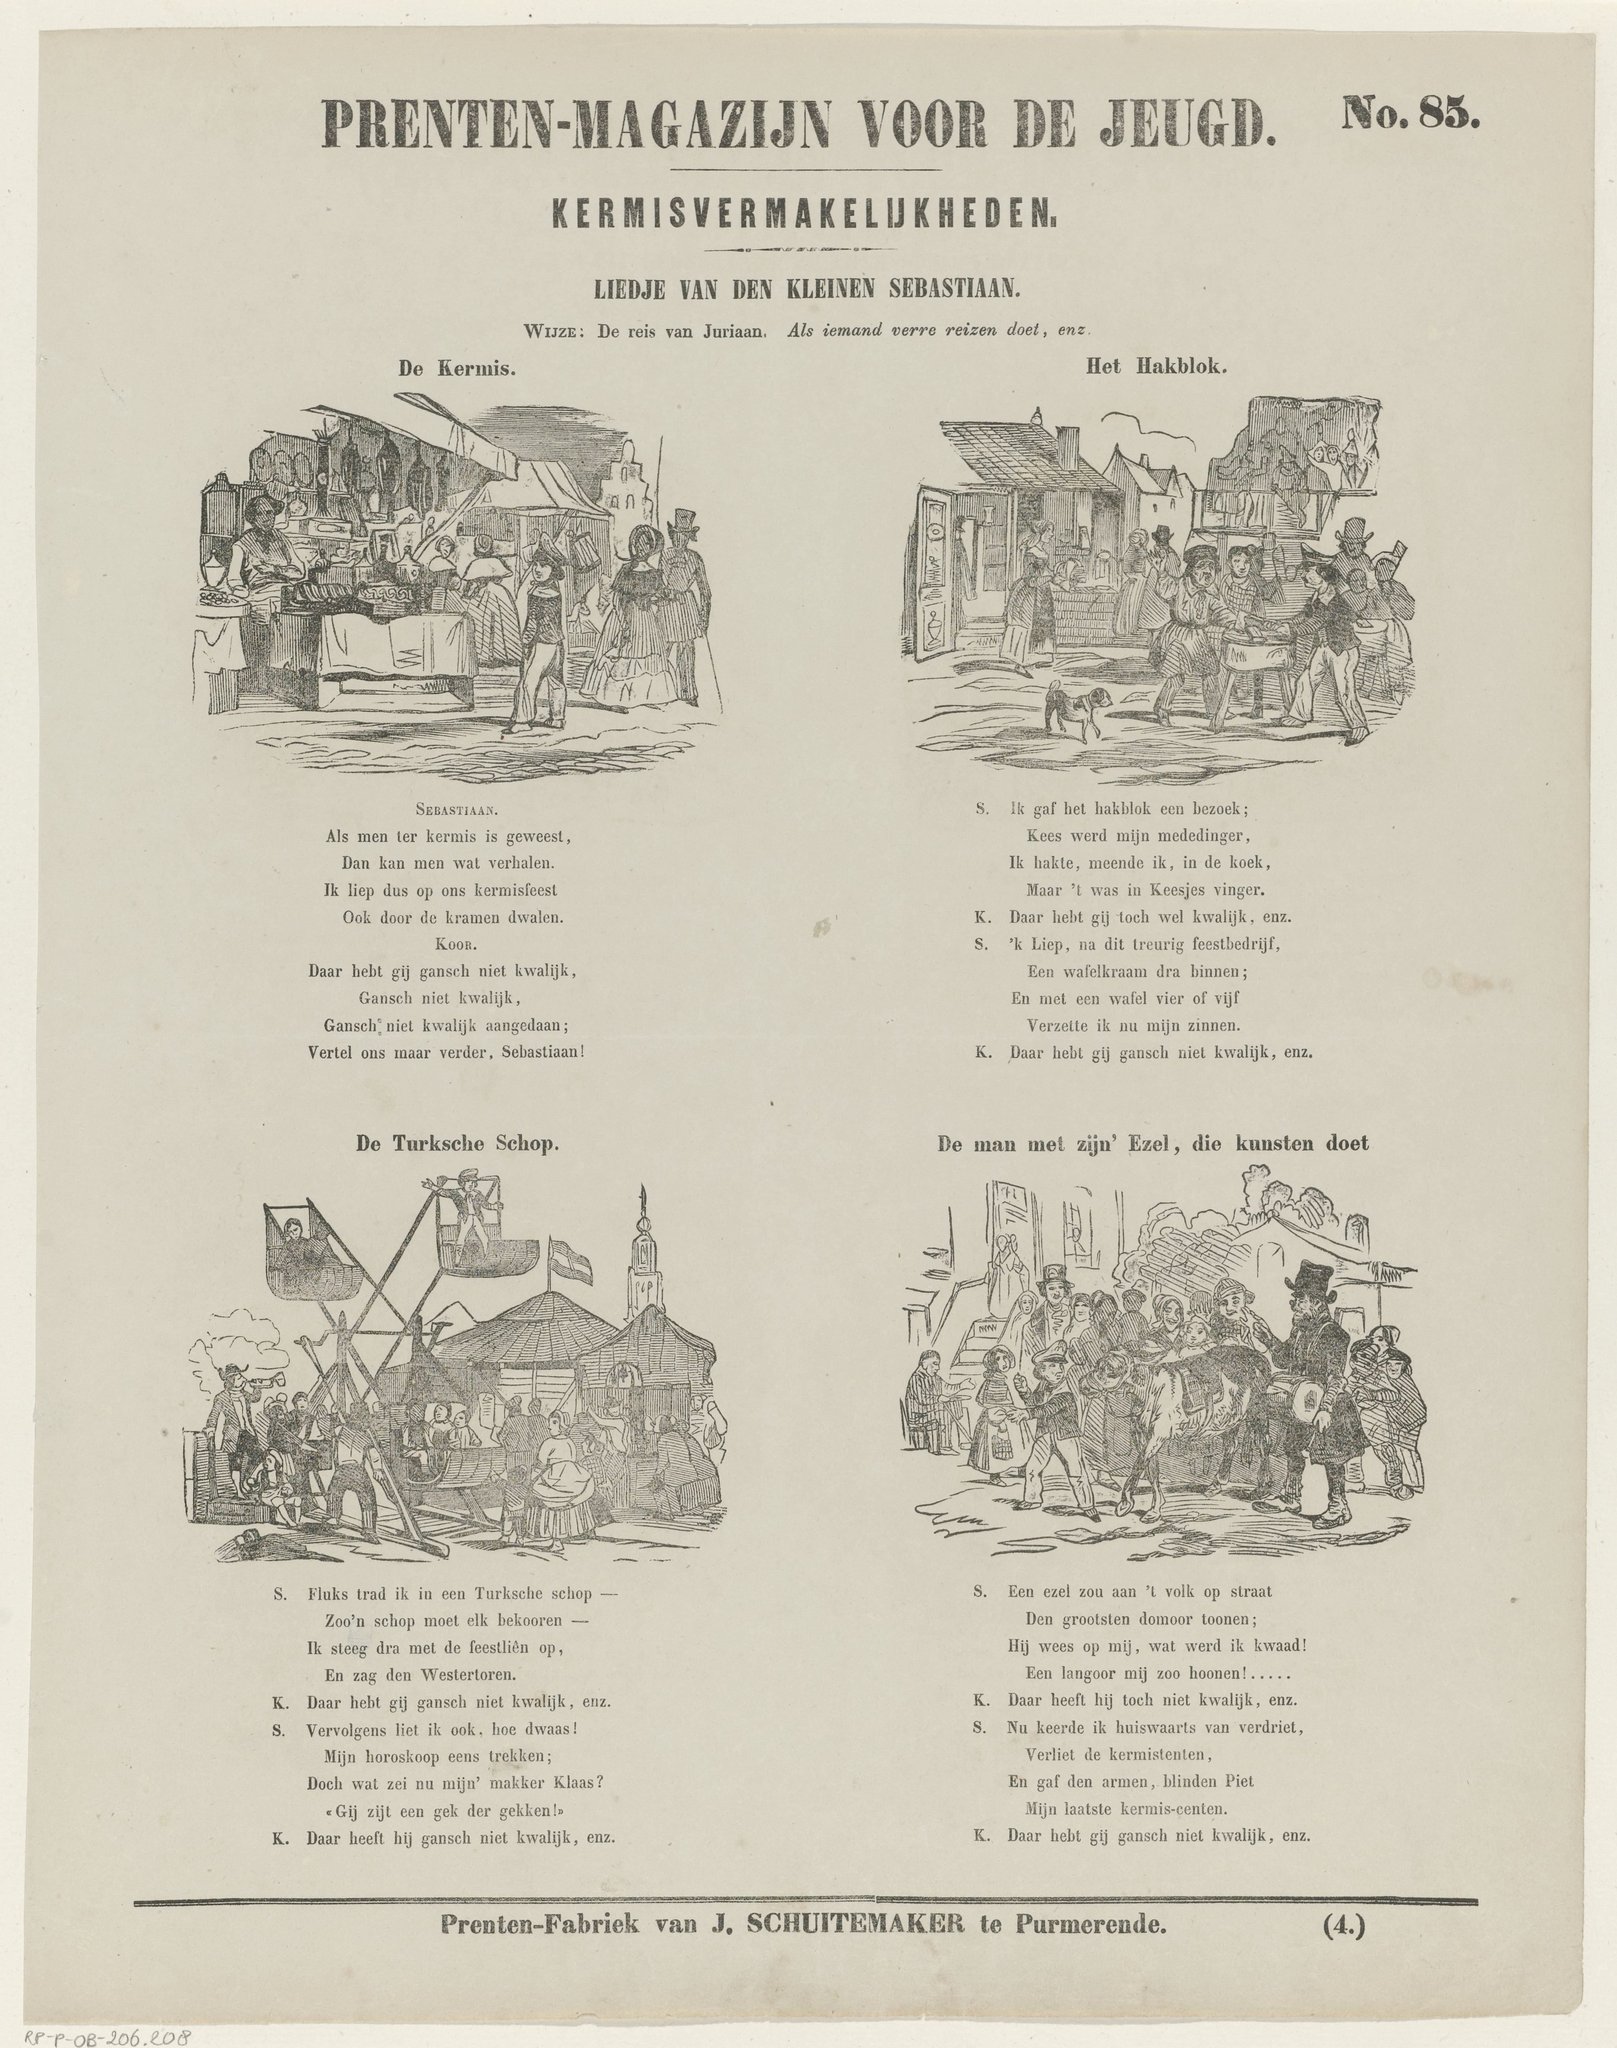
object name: print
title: Kermisvermakelijkheden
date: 1850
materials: paper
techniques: letterpress printing, engraving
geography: purmerend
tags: fancy fair, performance in the open air (pleasure fair), pleasure fair and circus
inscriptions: collector's mark: Lugt 2760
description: Na voltooiing van de acht jaargangen van de reeks 'Prenten-magazijn voor de jeugd' in 1850 heeft Jan Schuitemaker al deze prenten heruitgegeven en omgenummerd als nr. 1 t/m 192. De oorspronkelijke jaargang wordt telkens nog vermeld rechtsonder op de prent. Binnen de jaargangen zijn prenten van hetzelfde thema in clusters van vier achter elkaar gezet.